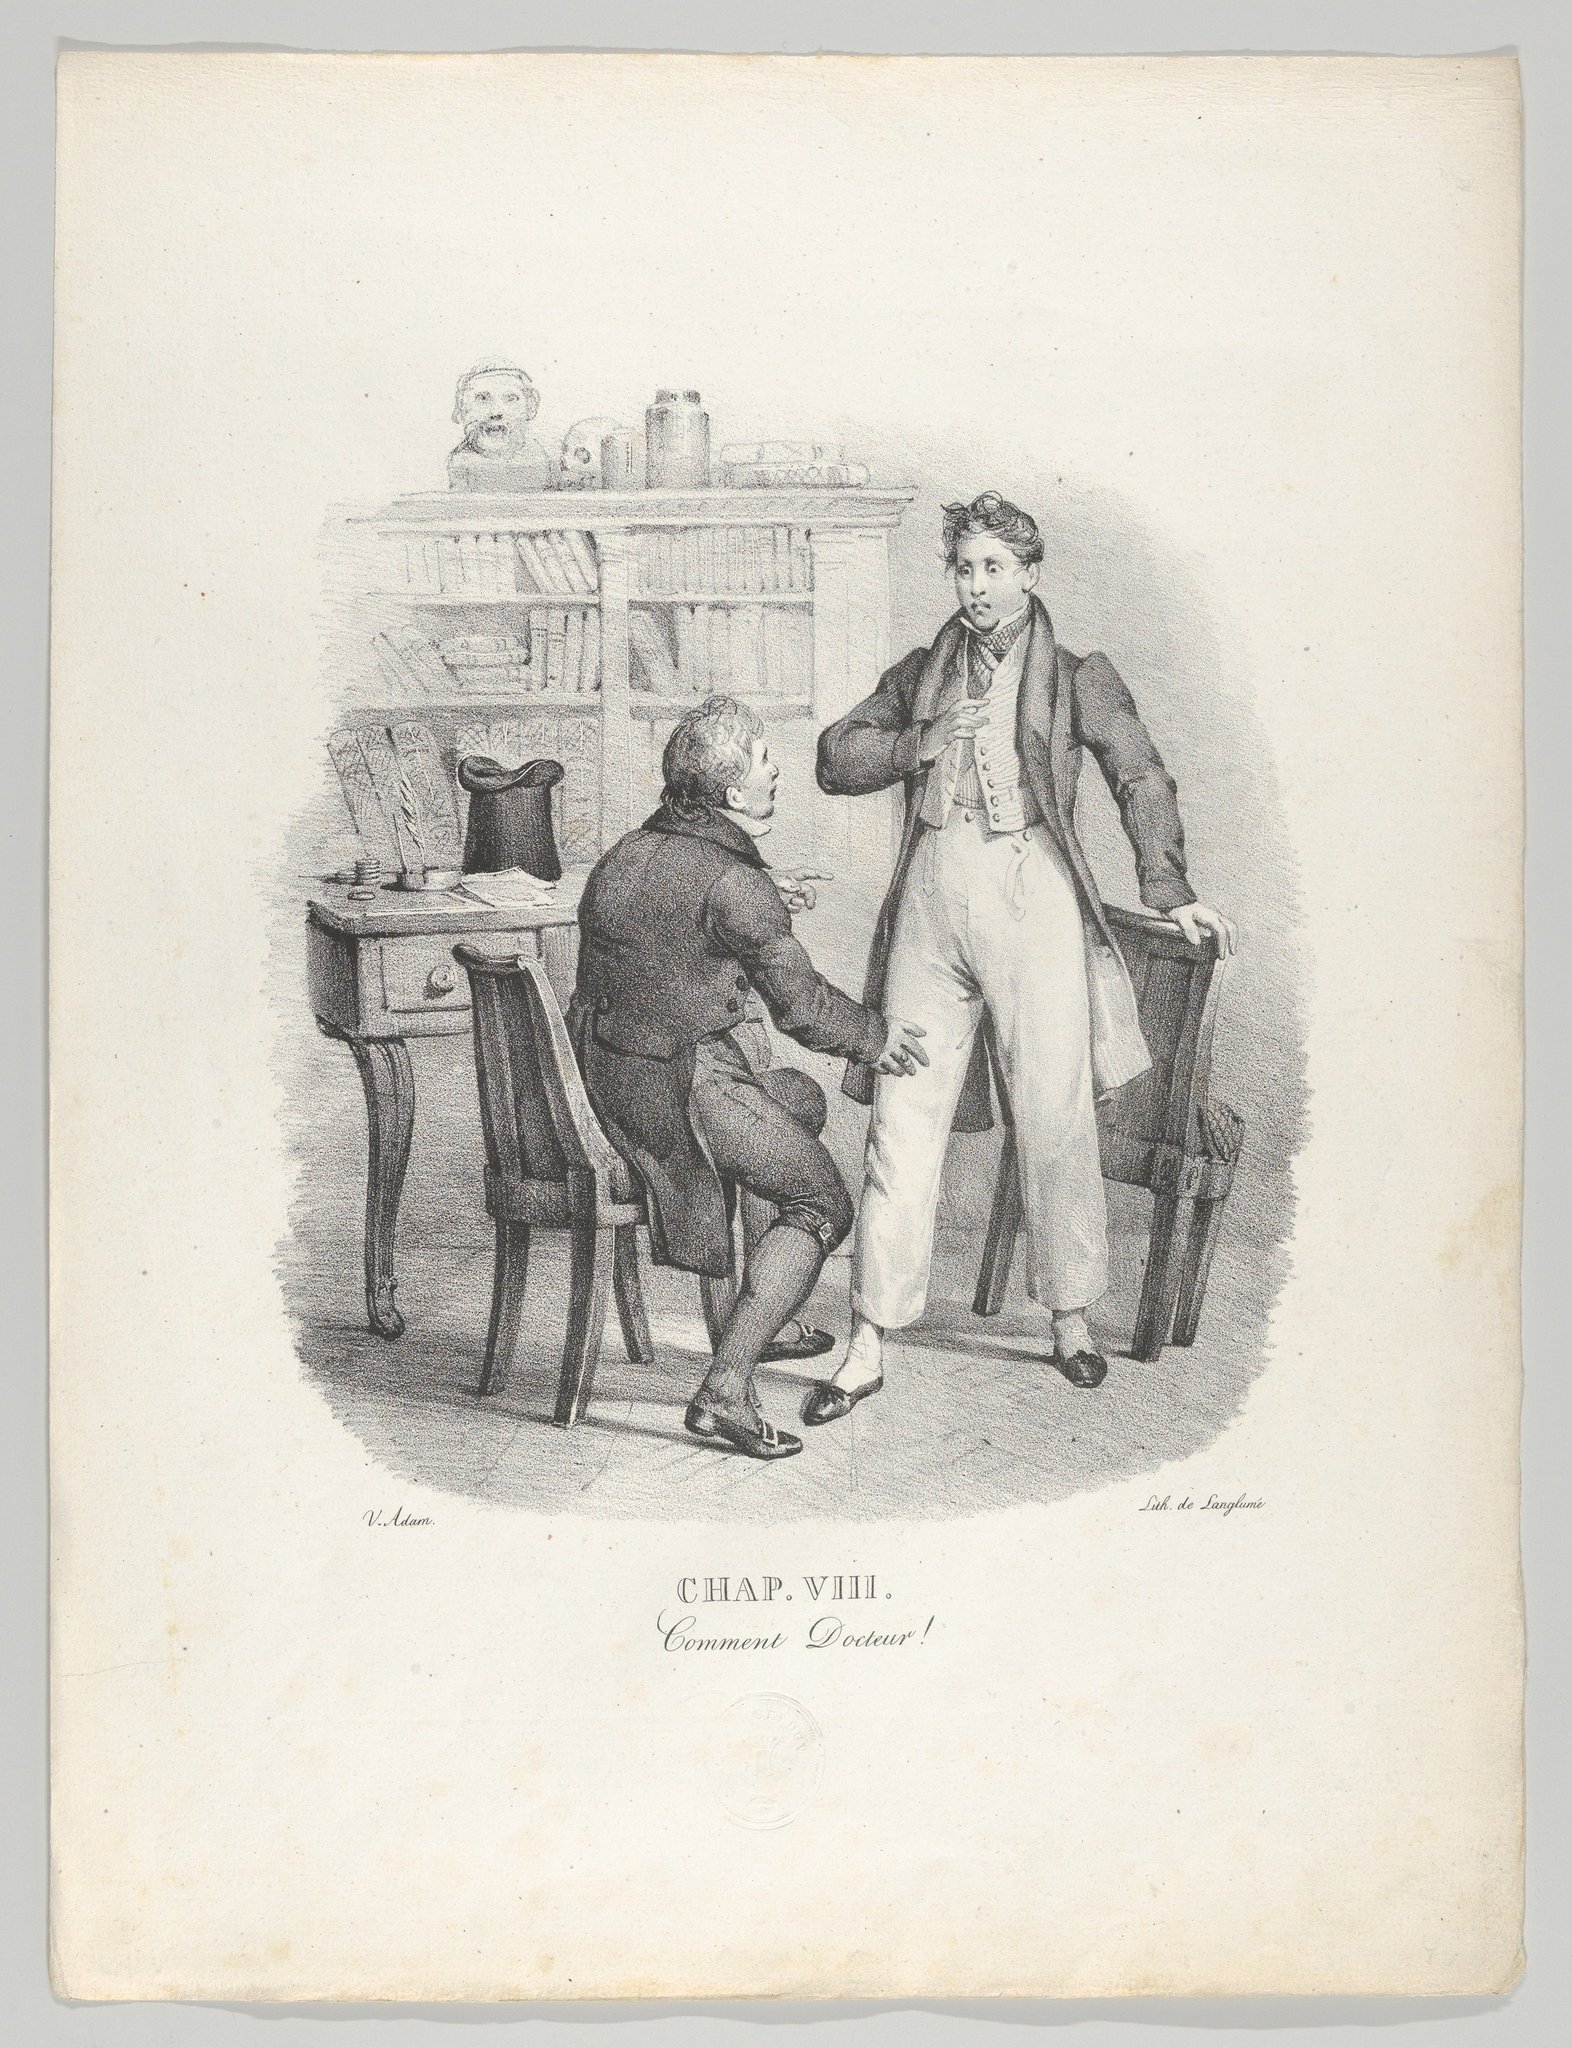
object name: print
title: Chap. VIII: Comment Docteur! (What, Doctor?)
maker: victor adam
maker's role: artist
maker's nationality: french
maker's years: 1801-1866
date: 1824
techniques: lithograph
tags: men